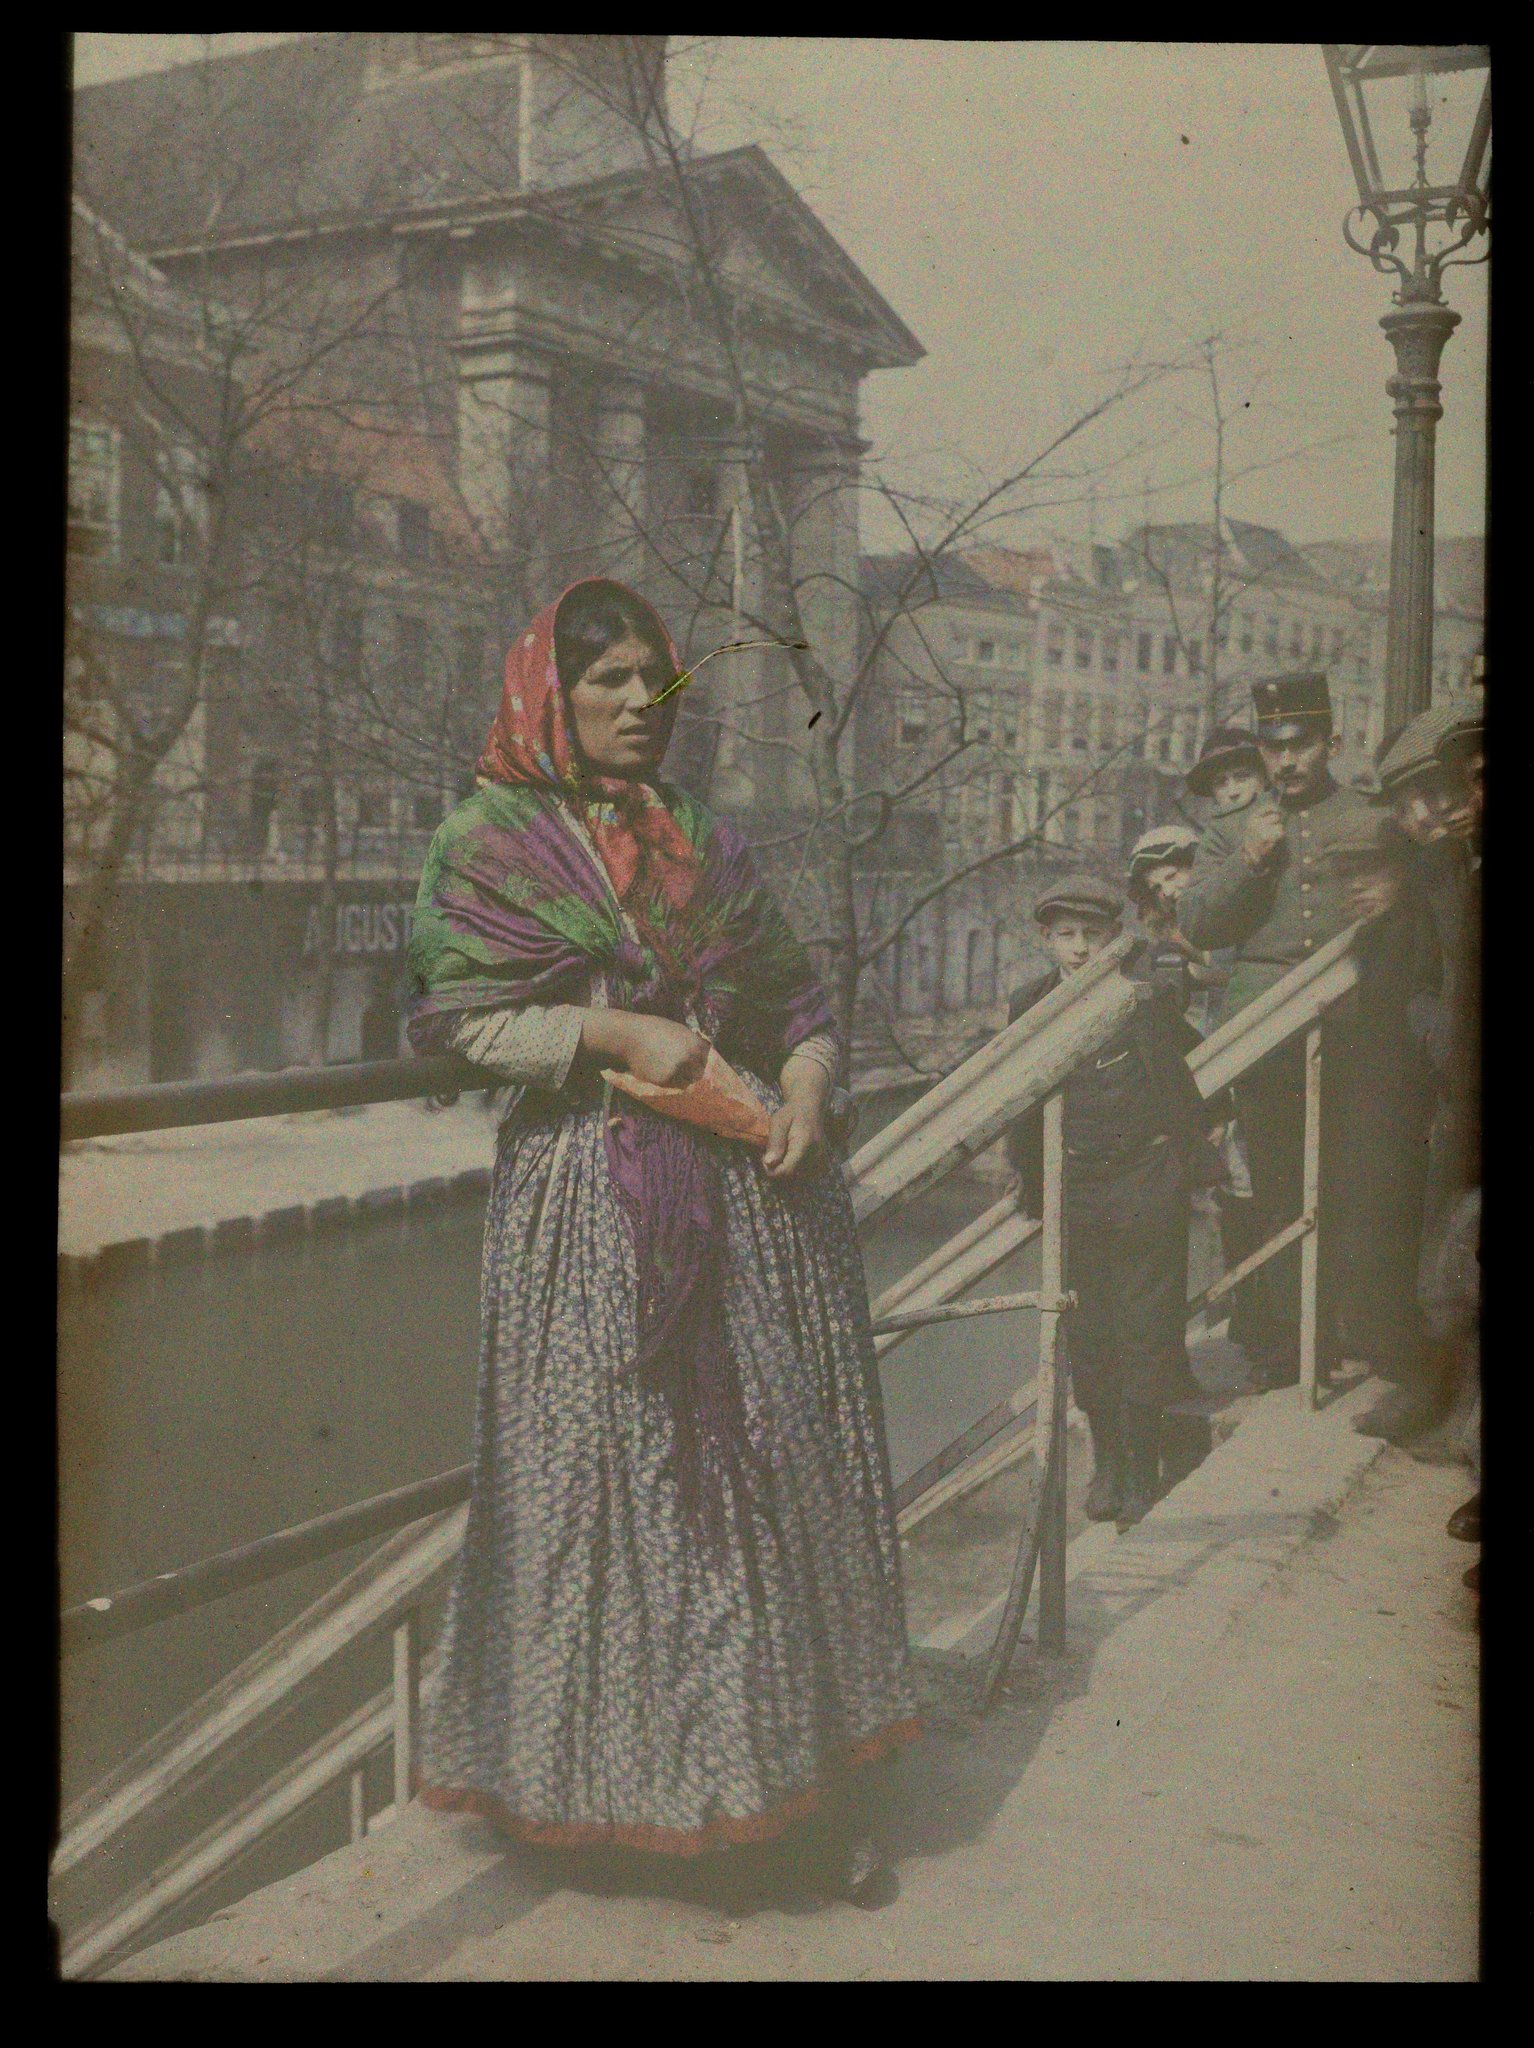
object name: photograph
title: Zigeunerin, Oudegracht, Utrecht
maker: sebastiaan alphonse van besten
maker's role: painter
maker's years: 1864-1926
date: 1915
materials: glass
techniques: autochrome process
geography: utrecht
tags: wandering communities: romani or roma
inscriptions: annotation: ‘Zigeunerin te Utrecht 1915 / S.A. v. Besten’